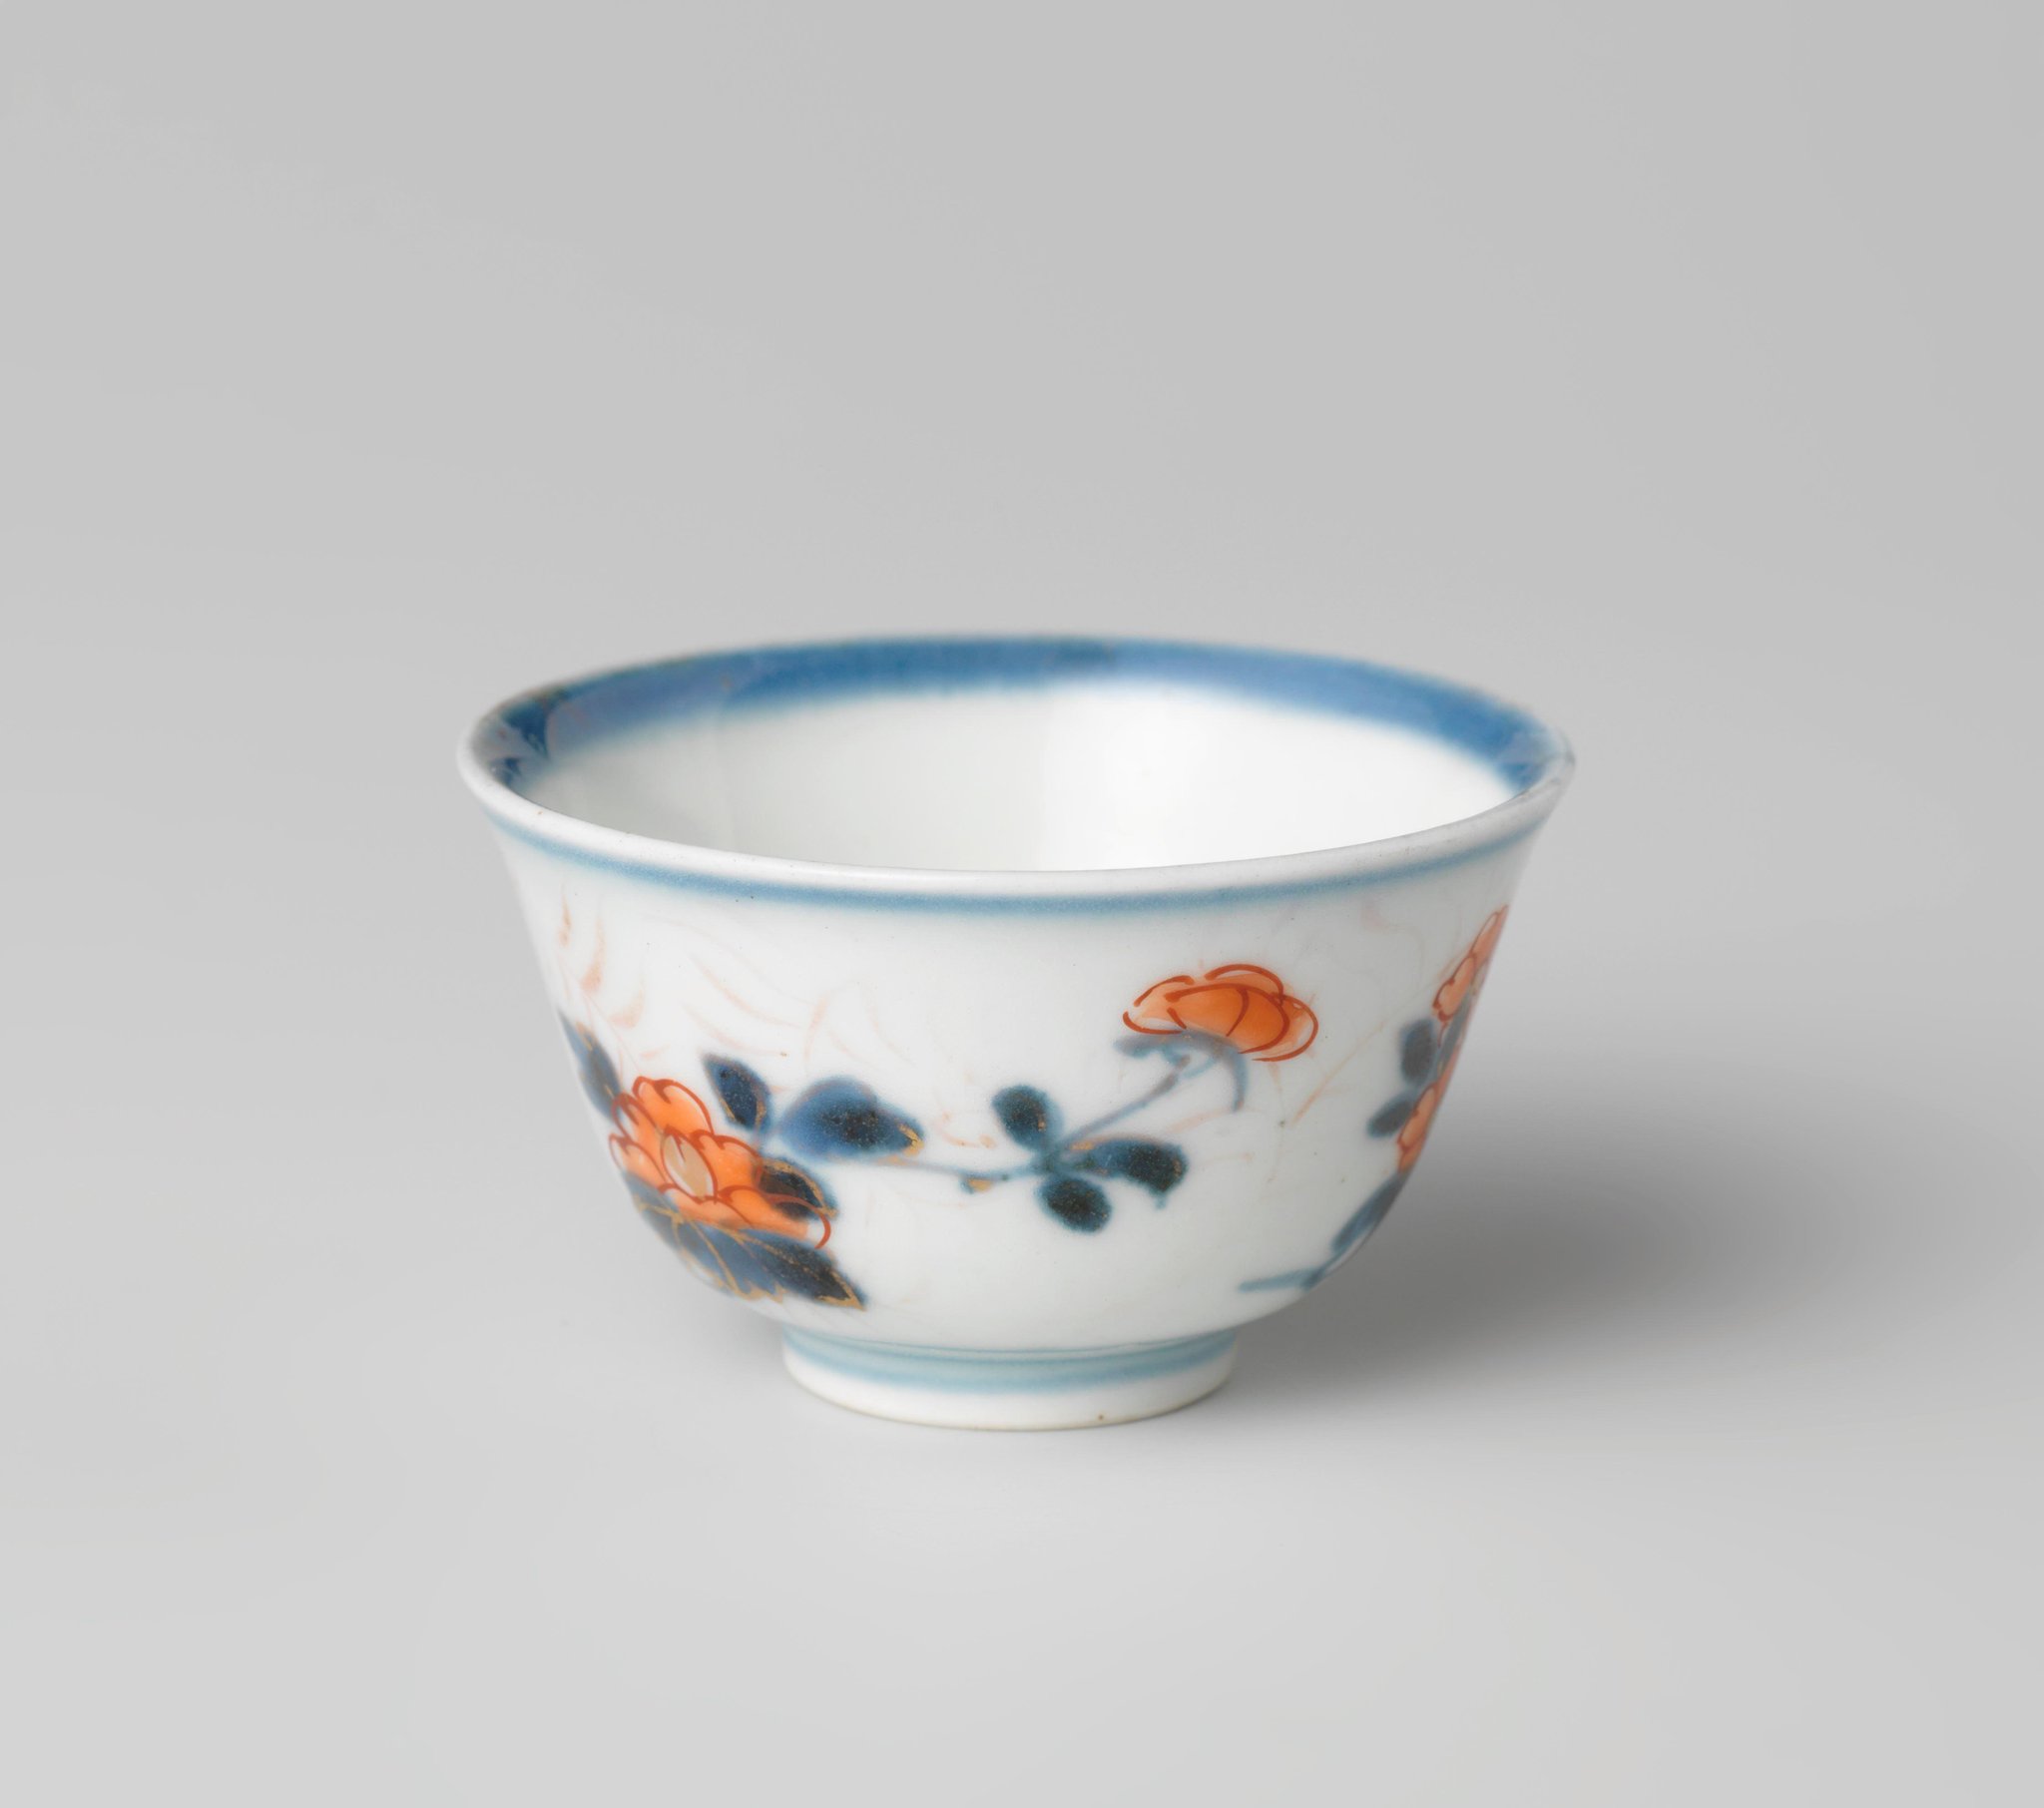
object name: cup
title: Bell-shaped cup with flower sprays and foliate scrolls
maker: Anonymous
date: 1800-1815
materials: cobalt, glaze, gold, paint, porcelain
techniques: firing, gilding, turning, vitrification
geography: japan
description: Klokvormige kop van porselein, beschilderd in onderglazuur blauw en op het glazuur rood en goud. Op de bodem een lotusrank in een medaillon. Op de wand medaillon bladranken met daartussen drie bloemtakken. De binnenrand is blauw. Imari.